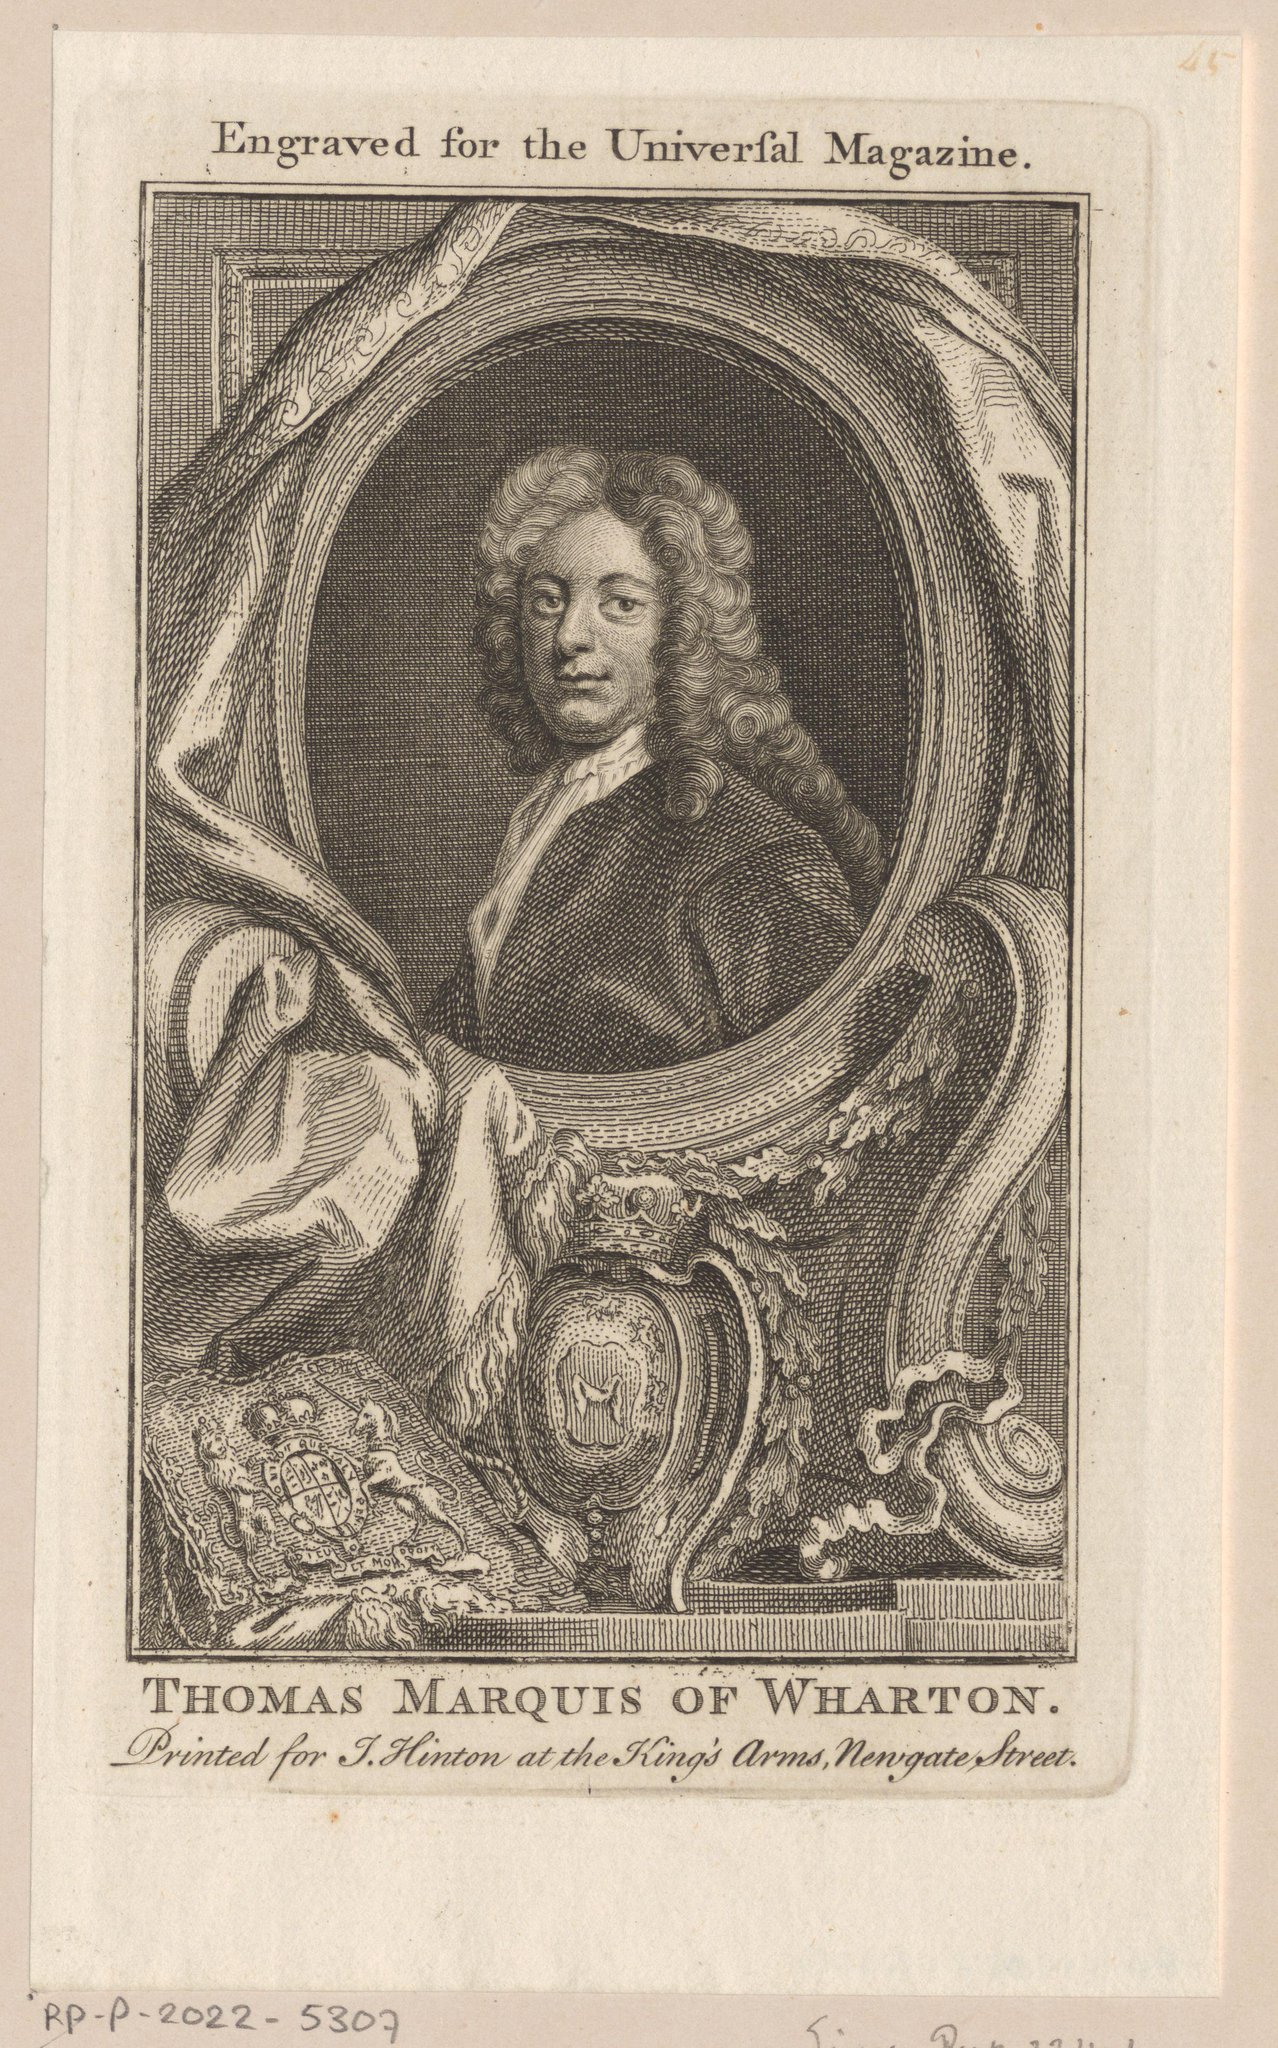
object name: print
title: Portret van Thomas Wharton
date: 1701-1761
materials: paper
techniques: engraving, etching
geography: london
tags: politician, historical persons, armorial bearing, heraldry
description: Prent uit: The Universal Magazine, nr. 28, januari 1761.